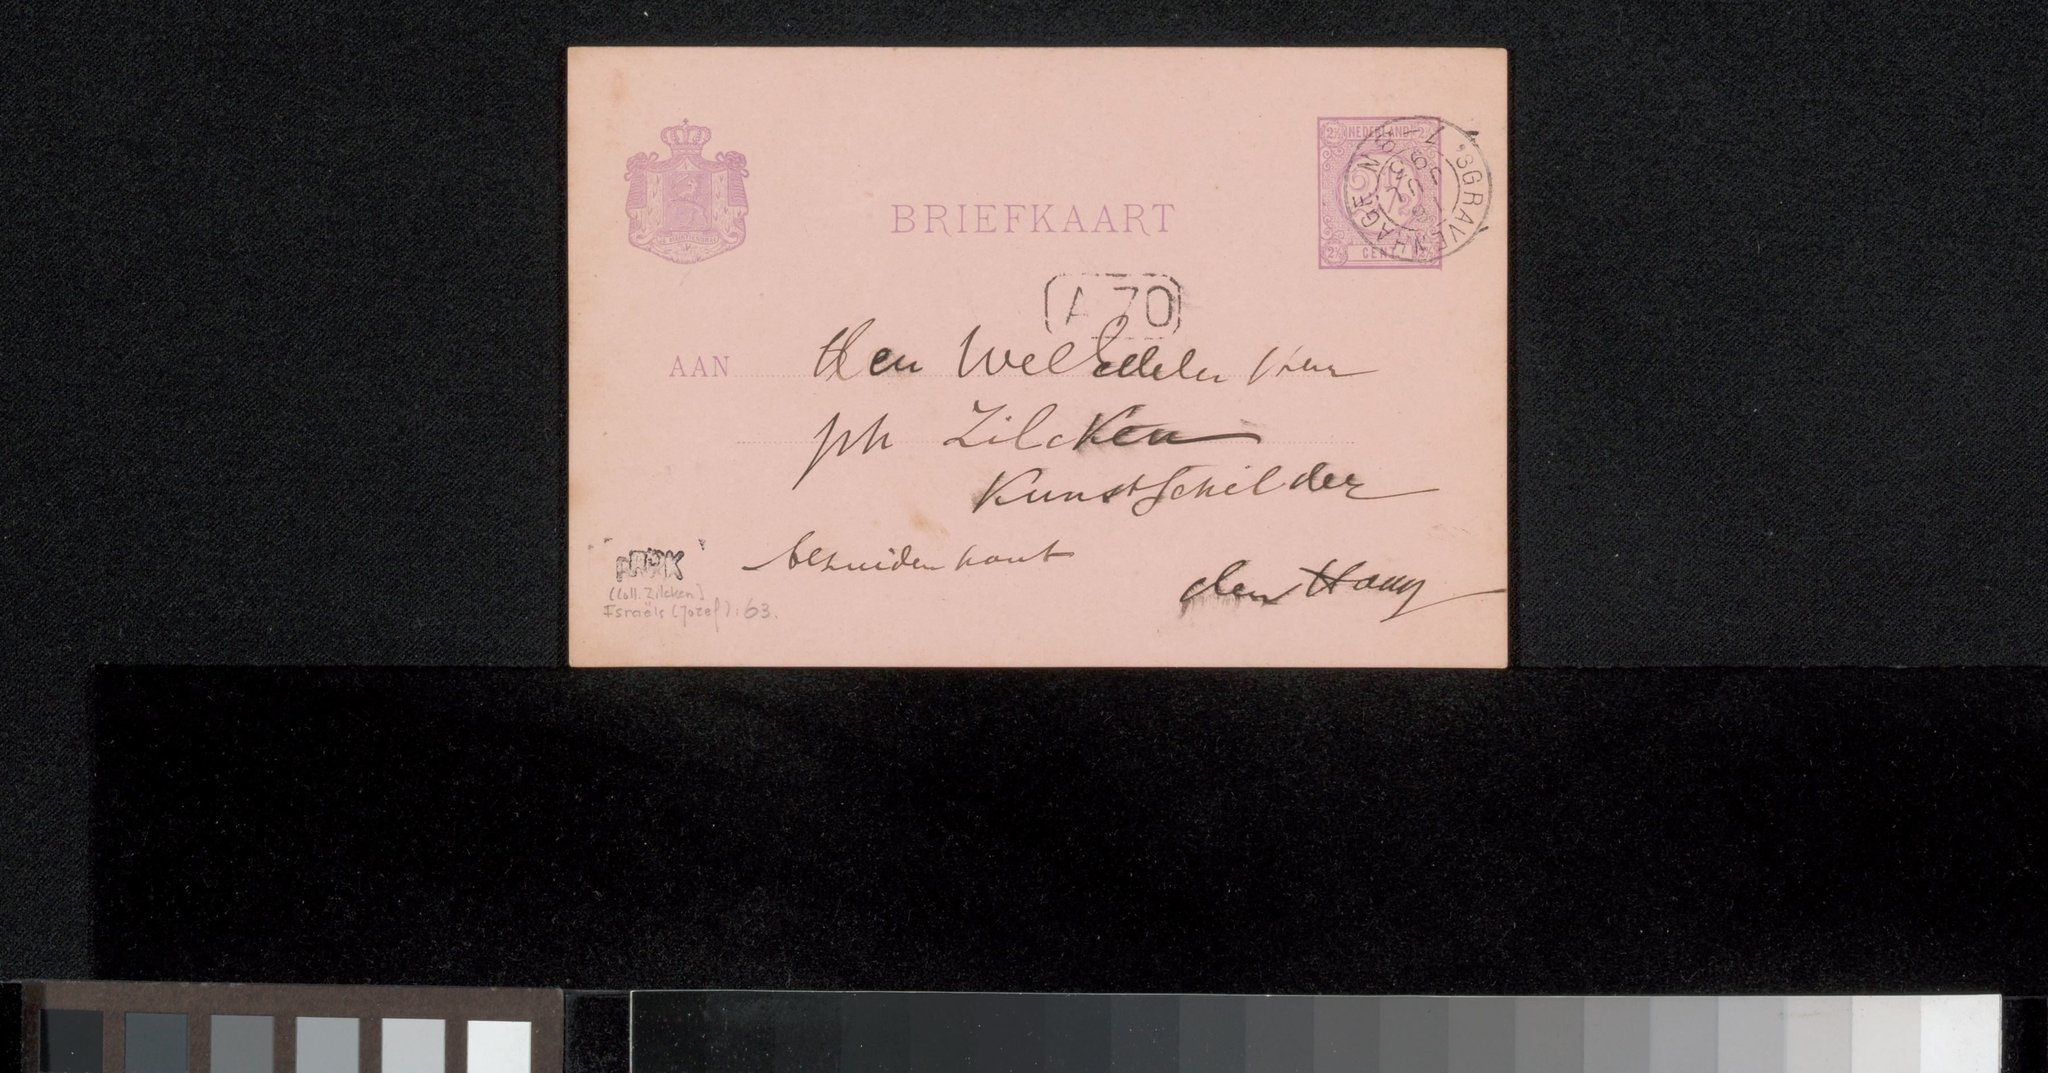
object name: postcard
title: Briefkaart aan Philip Zilcken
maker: jozef israëls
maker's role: draughtsman, painter, print maker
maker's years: 1824-1911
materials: cardboard, ink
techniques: pen, writing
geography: the hague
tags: philip zilcken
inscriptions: collector's mark: ‘RPK’